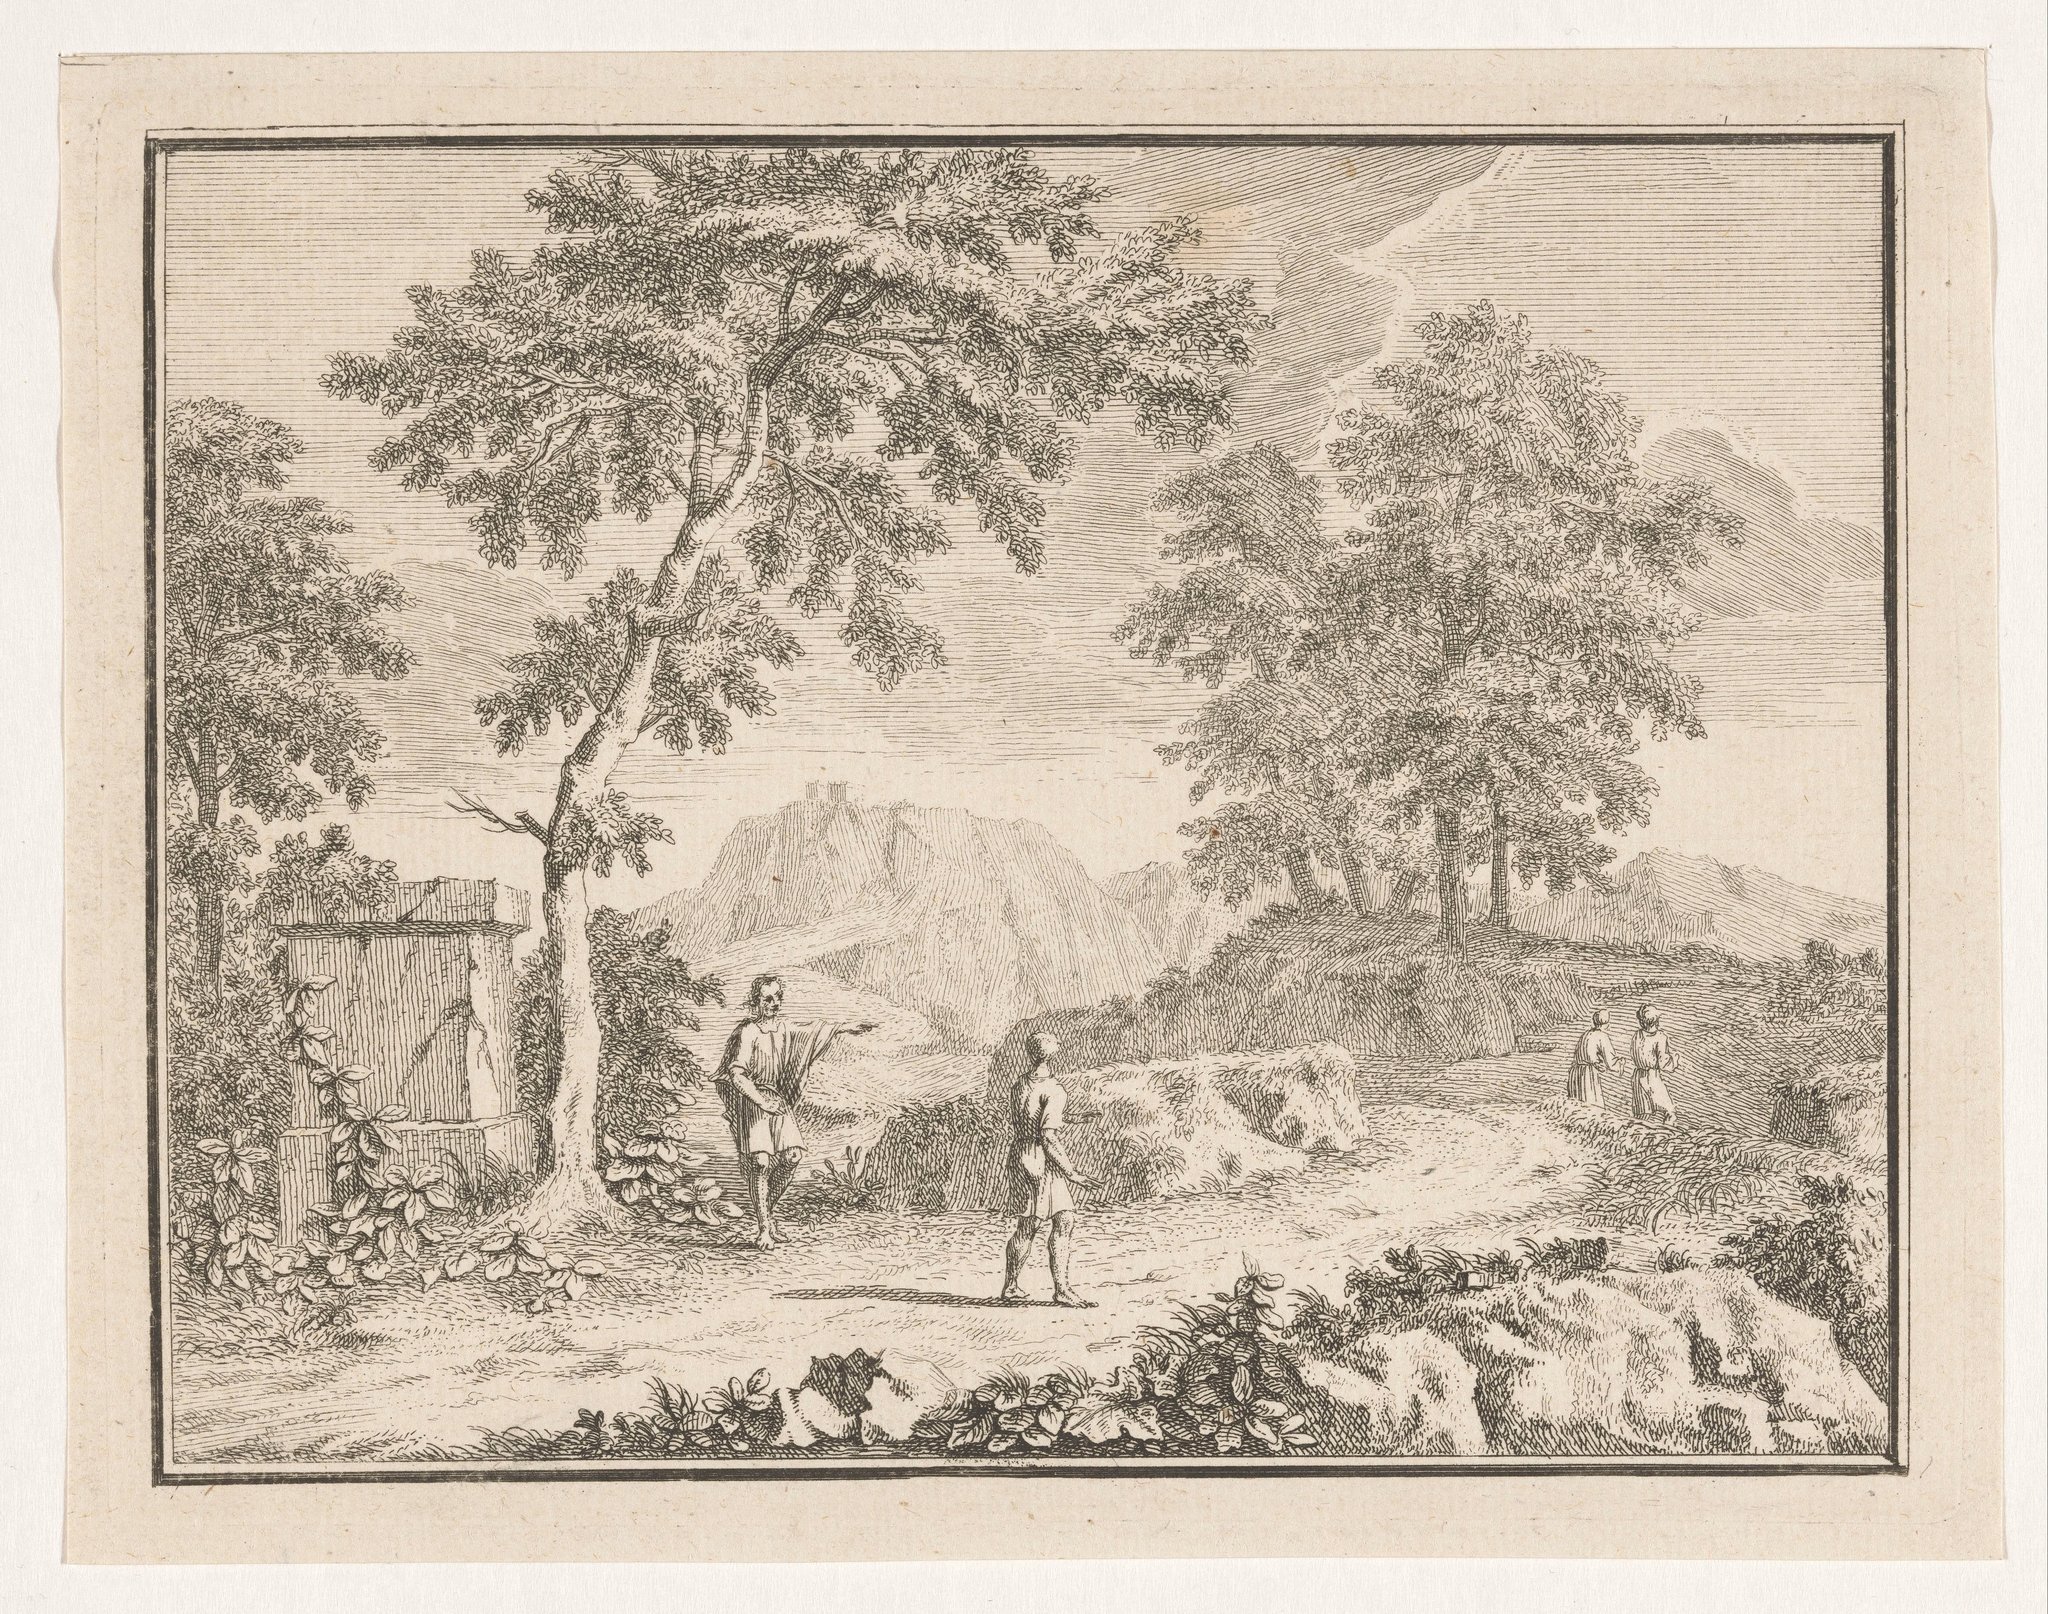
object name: print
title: Arcadisch landschap met man die de weg wijst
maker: louis fabritius dubourg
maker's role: draughtsman, print maker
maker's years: 1693-1775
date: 1713-1775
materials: paper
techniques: etching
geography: amsterdam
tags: pastorals, arcadian scenes, asking the way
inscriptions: collector's mark: Lugt 240